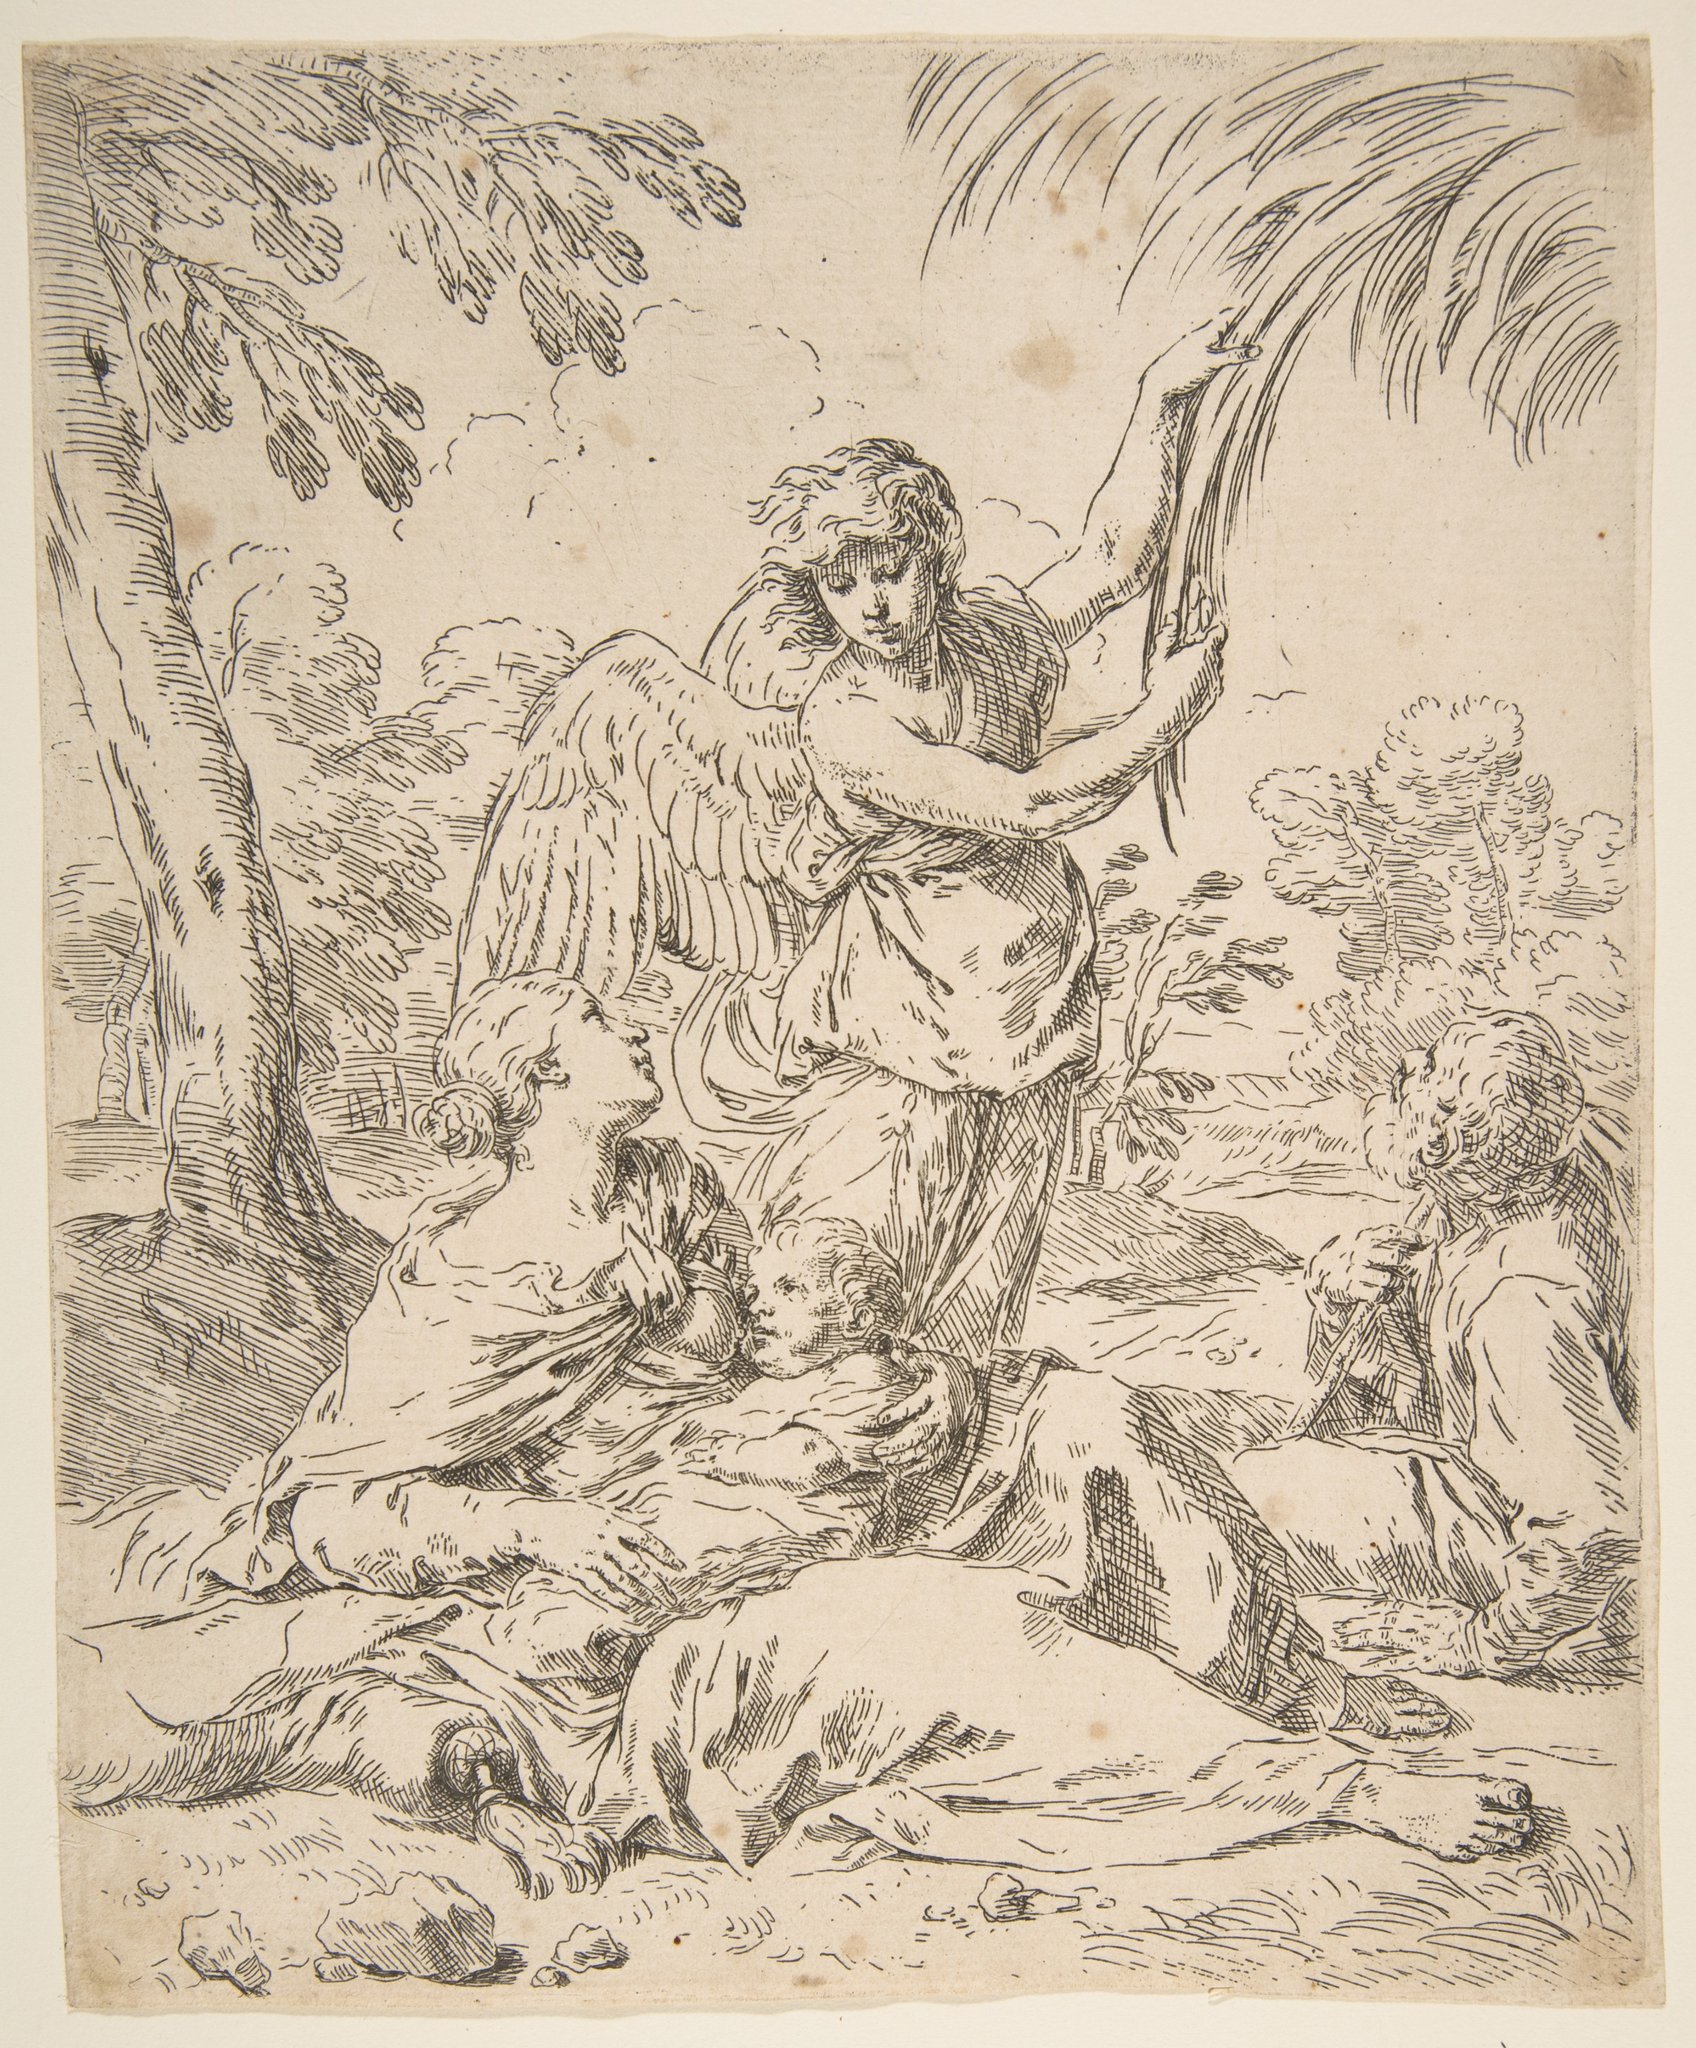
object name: print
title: Repose in Egypt, Mary nursing the infant Christ while an angel pulls at tree branches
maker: simone cantarini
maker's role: artist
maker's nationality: italian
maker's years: 1612-1648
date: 1639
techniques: etching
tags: men,trees,angels,virgin mary,jesus